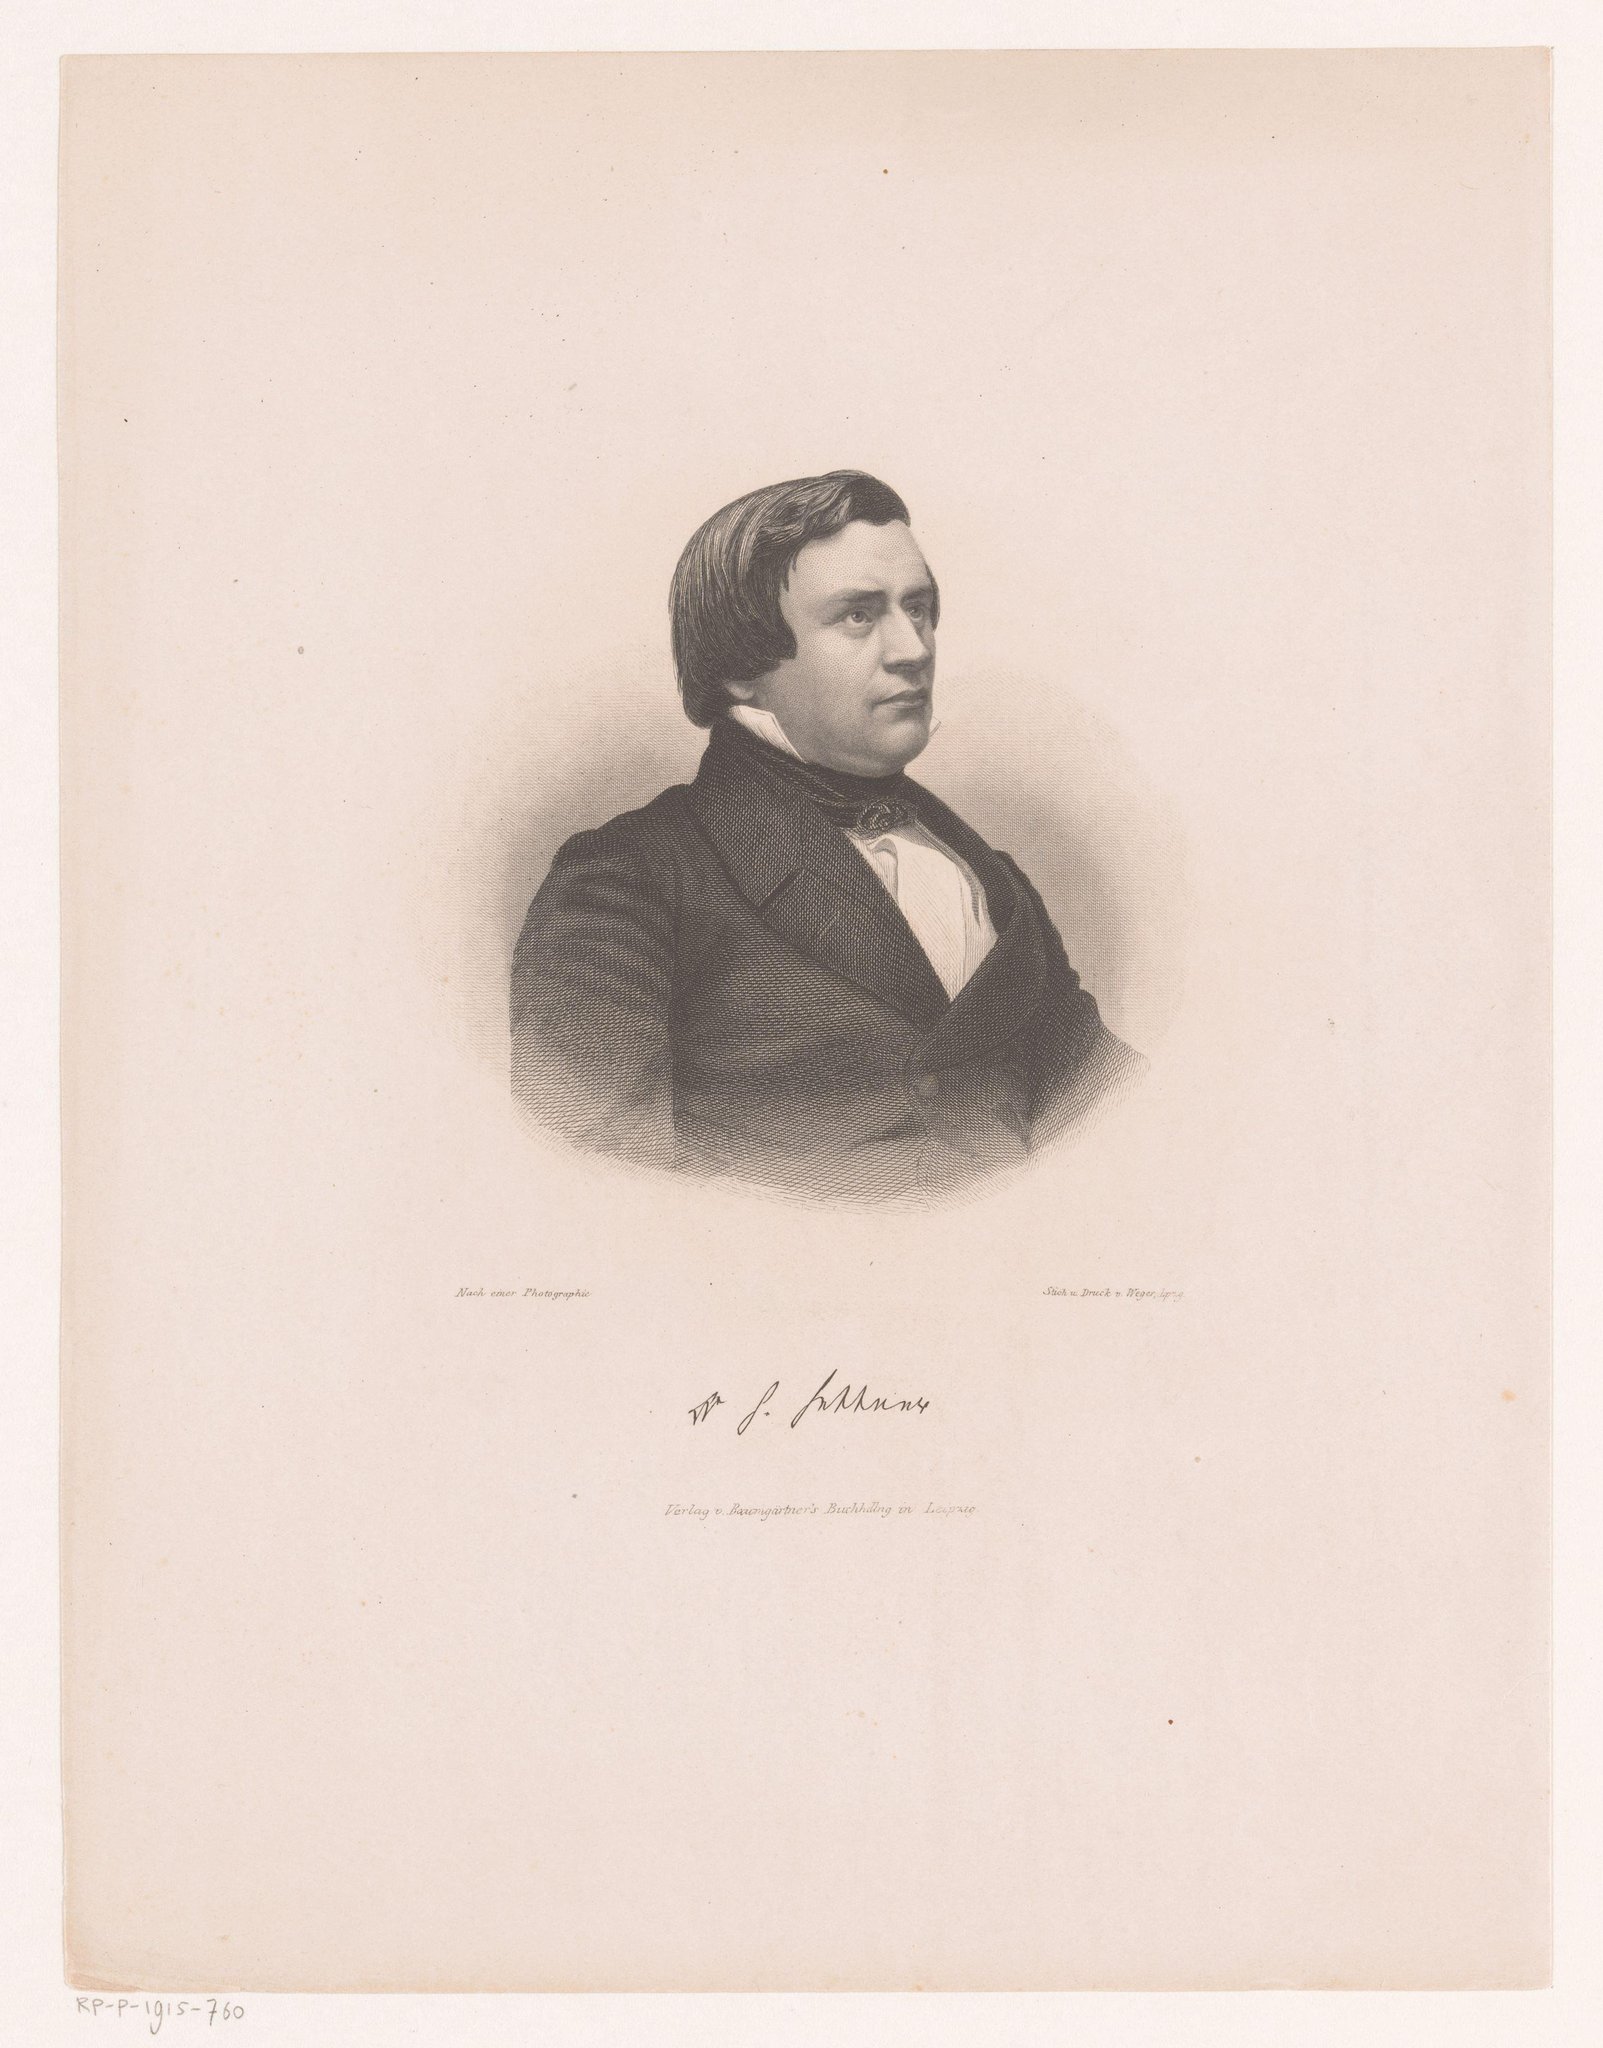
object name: print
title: Portret van Hermann Hettner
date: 1849-1892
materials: paper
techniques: engraving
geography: leipzig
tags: historical persons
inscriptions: collector's mark: Lugt 2228